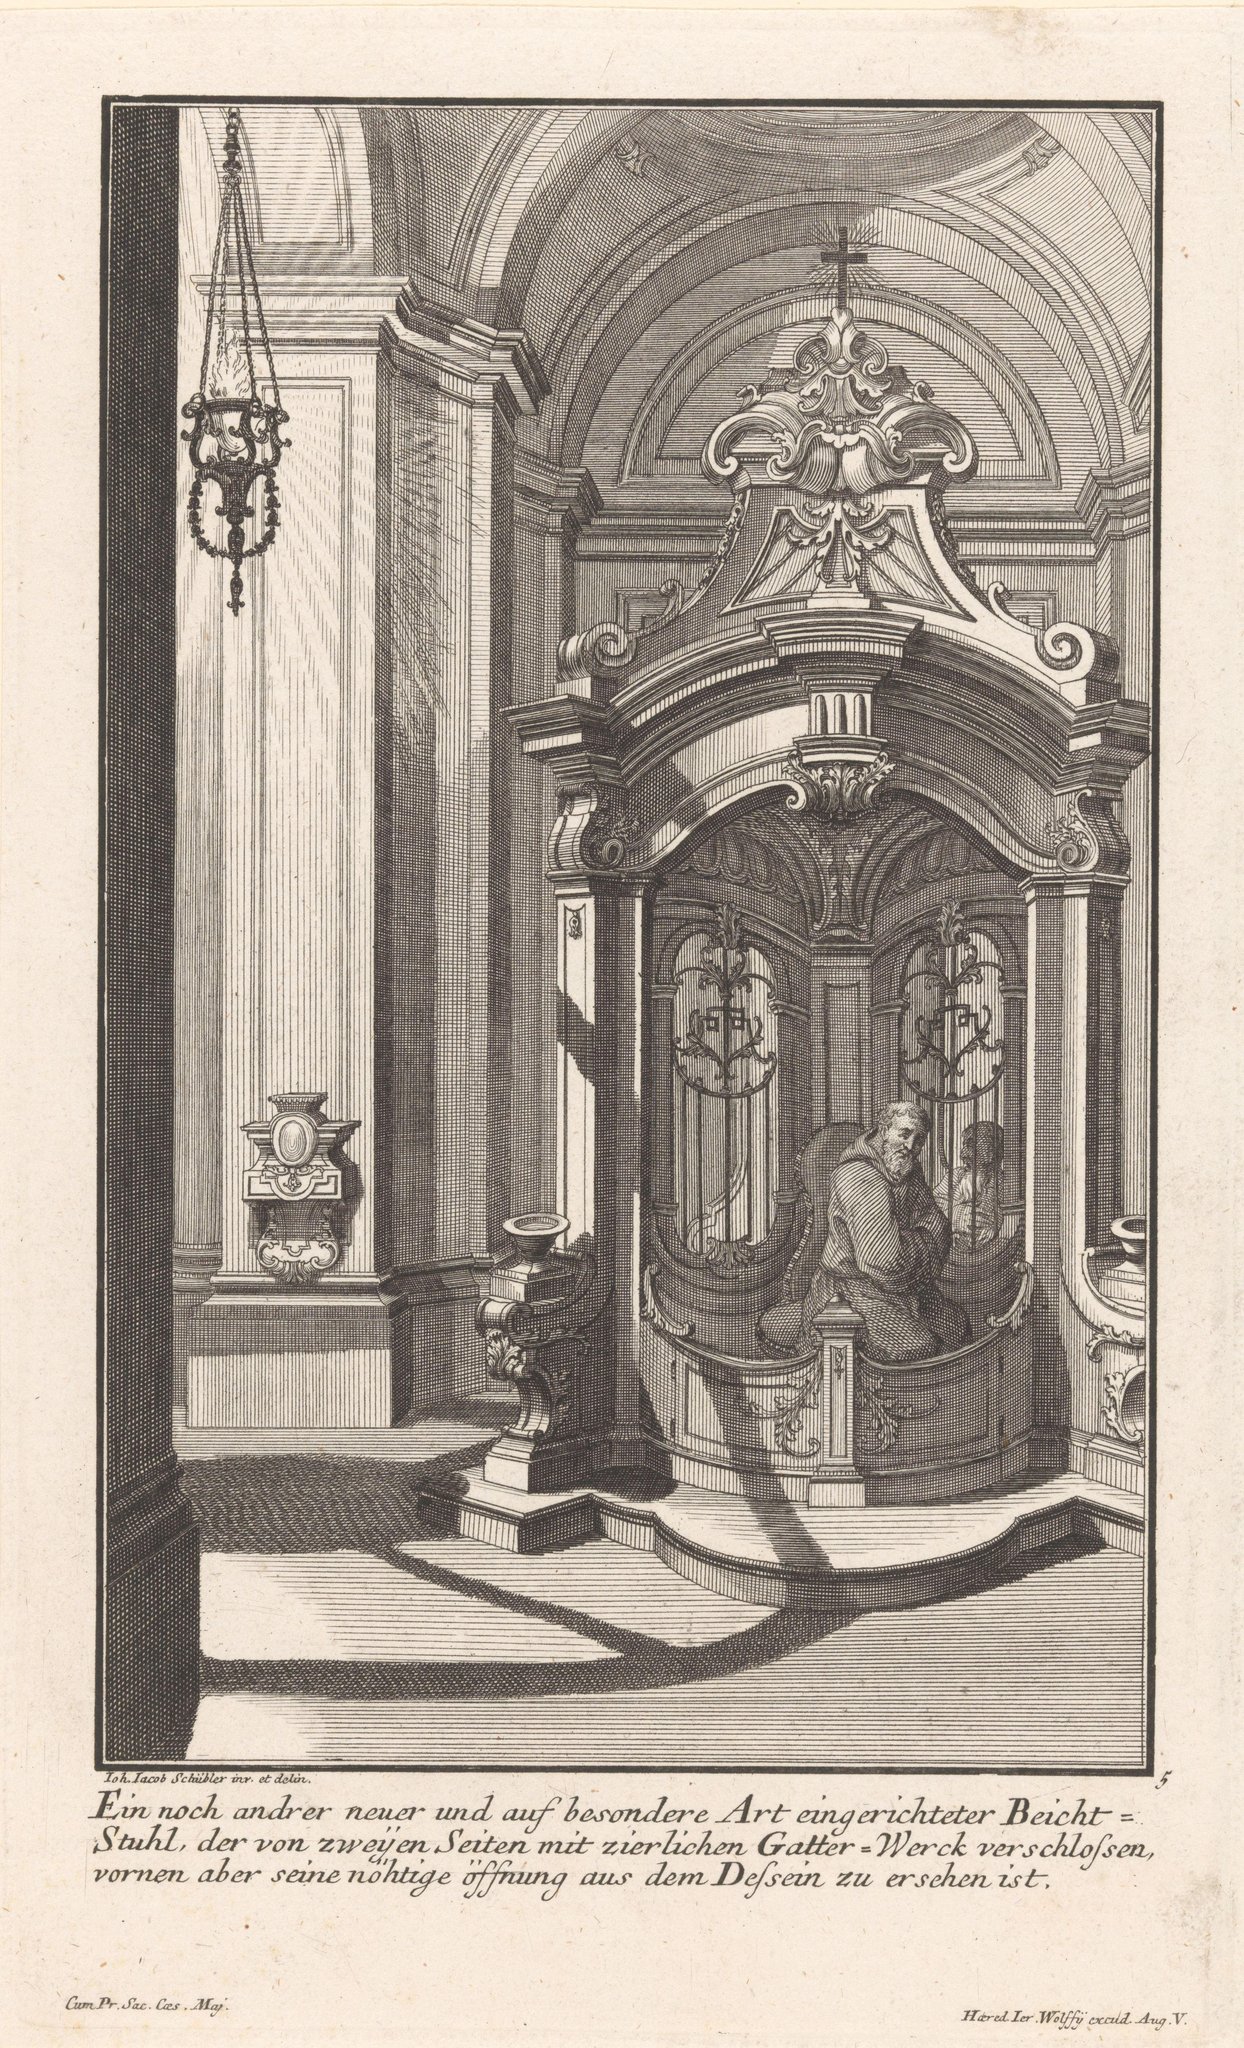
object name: ornament print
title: Biechtstoel met monnik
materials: paper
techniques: engraving, etching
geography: augsburg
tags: monk(s), friar(s), confessional ~ part of the confession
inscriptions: collector's mark: Lugt 2228, collector's mark: Lugt 2760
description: Een geornamenteerde biechtstoel, bekroond met een kruis. Een monnik neemt de biecht af van een man met baard rechts. In de ondermarge een drieregelige Duitse tekst.